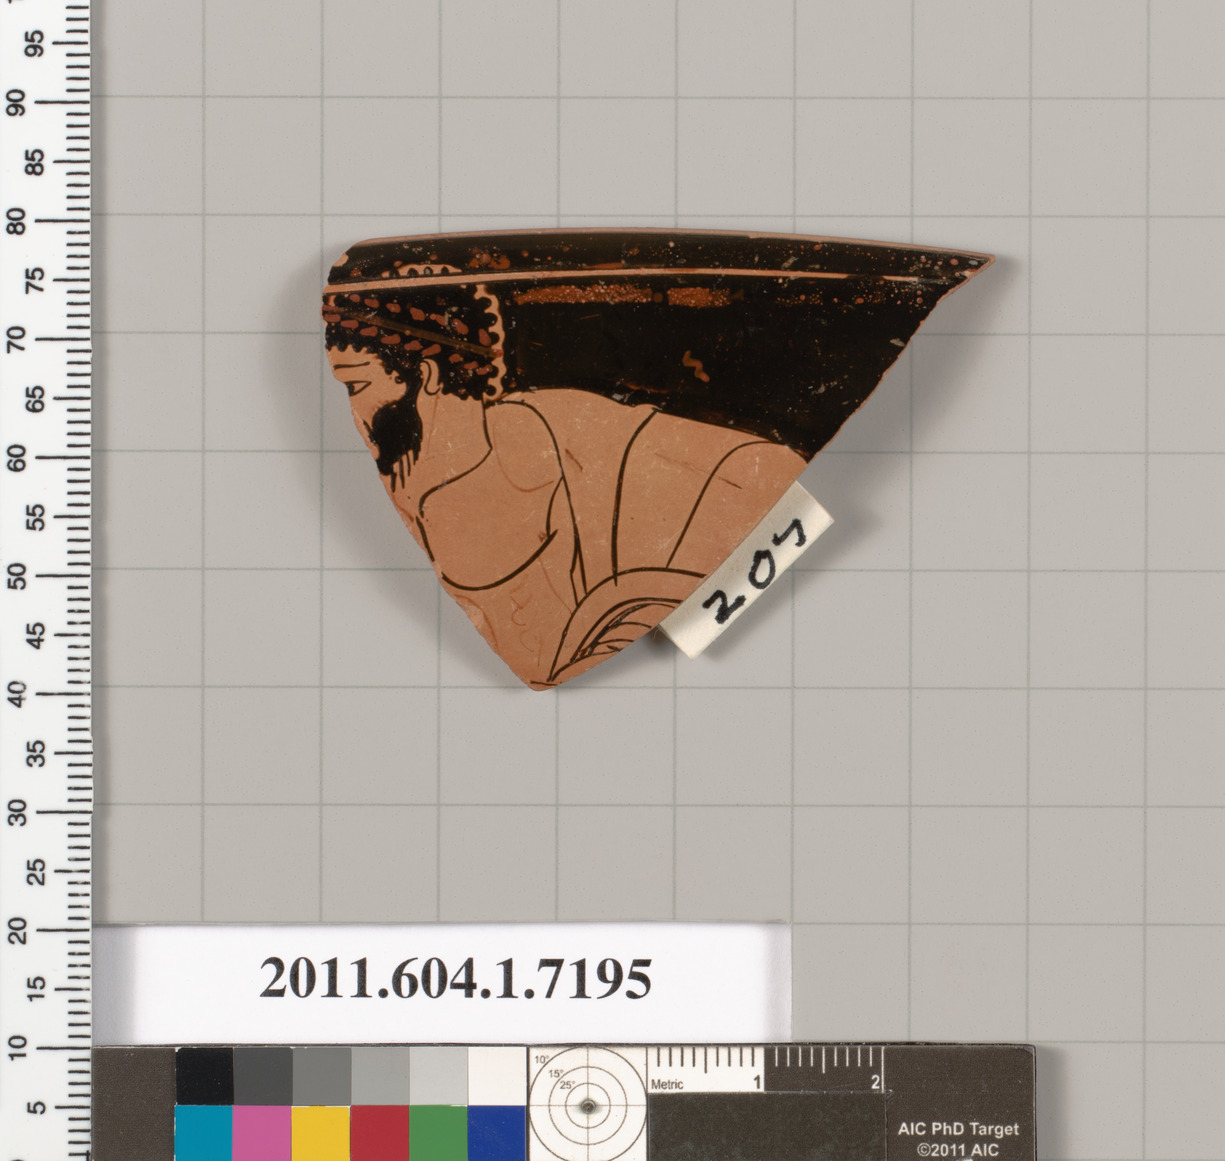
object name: kylix fragment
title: Terracotta rim fragment of a kylix (drinking cup)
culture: greek, attic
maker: makron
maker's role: artist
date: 500-480 BCE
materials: terracotta